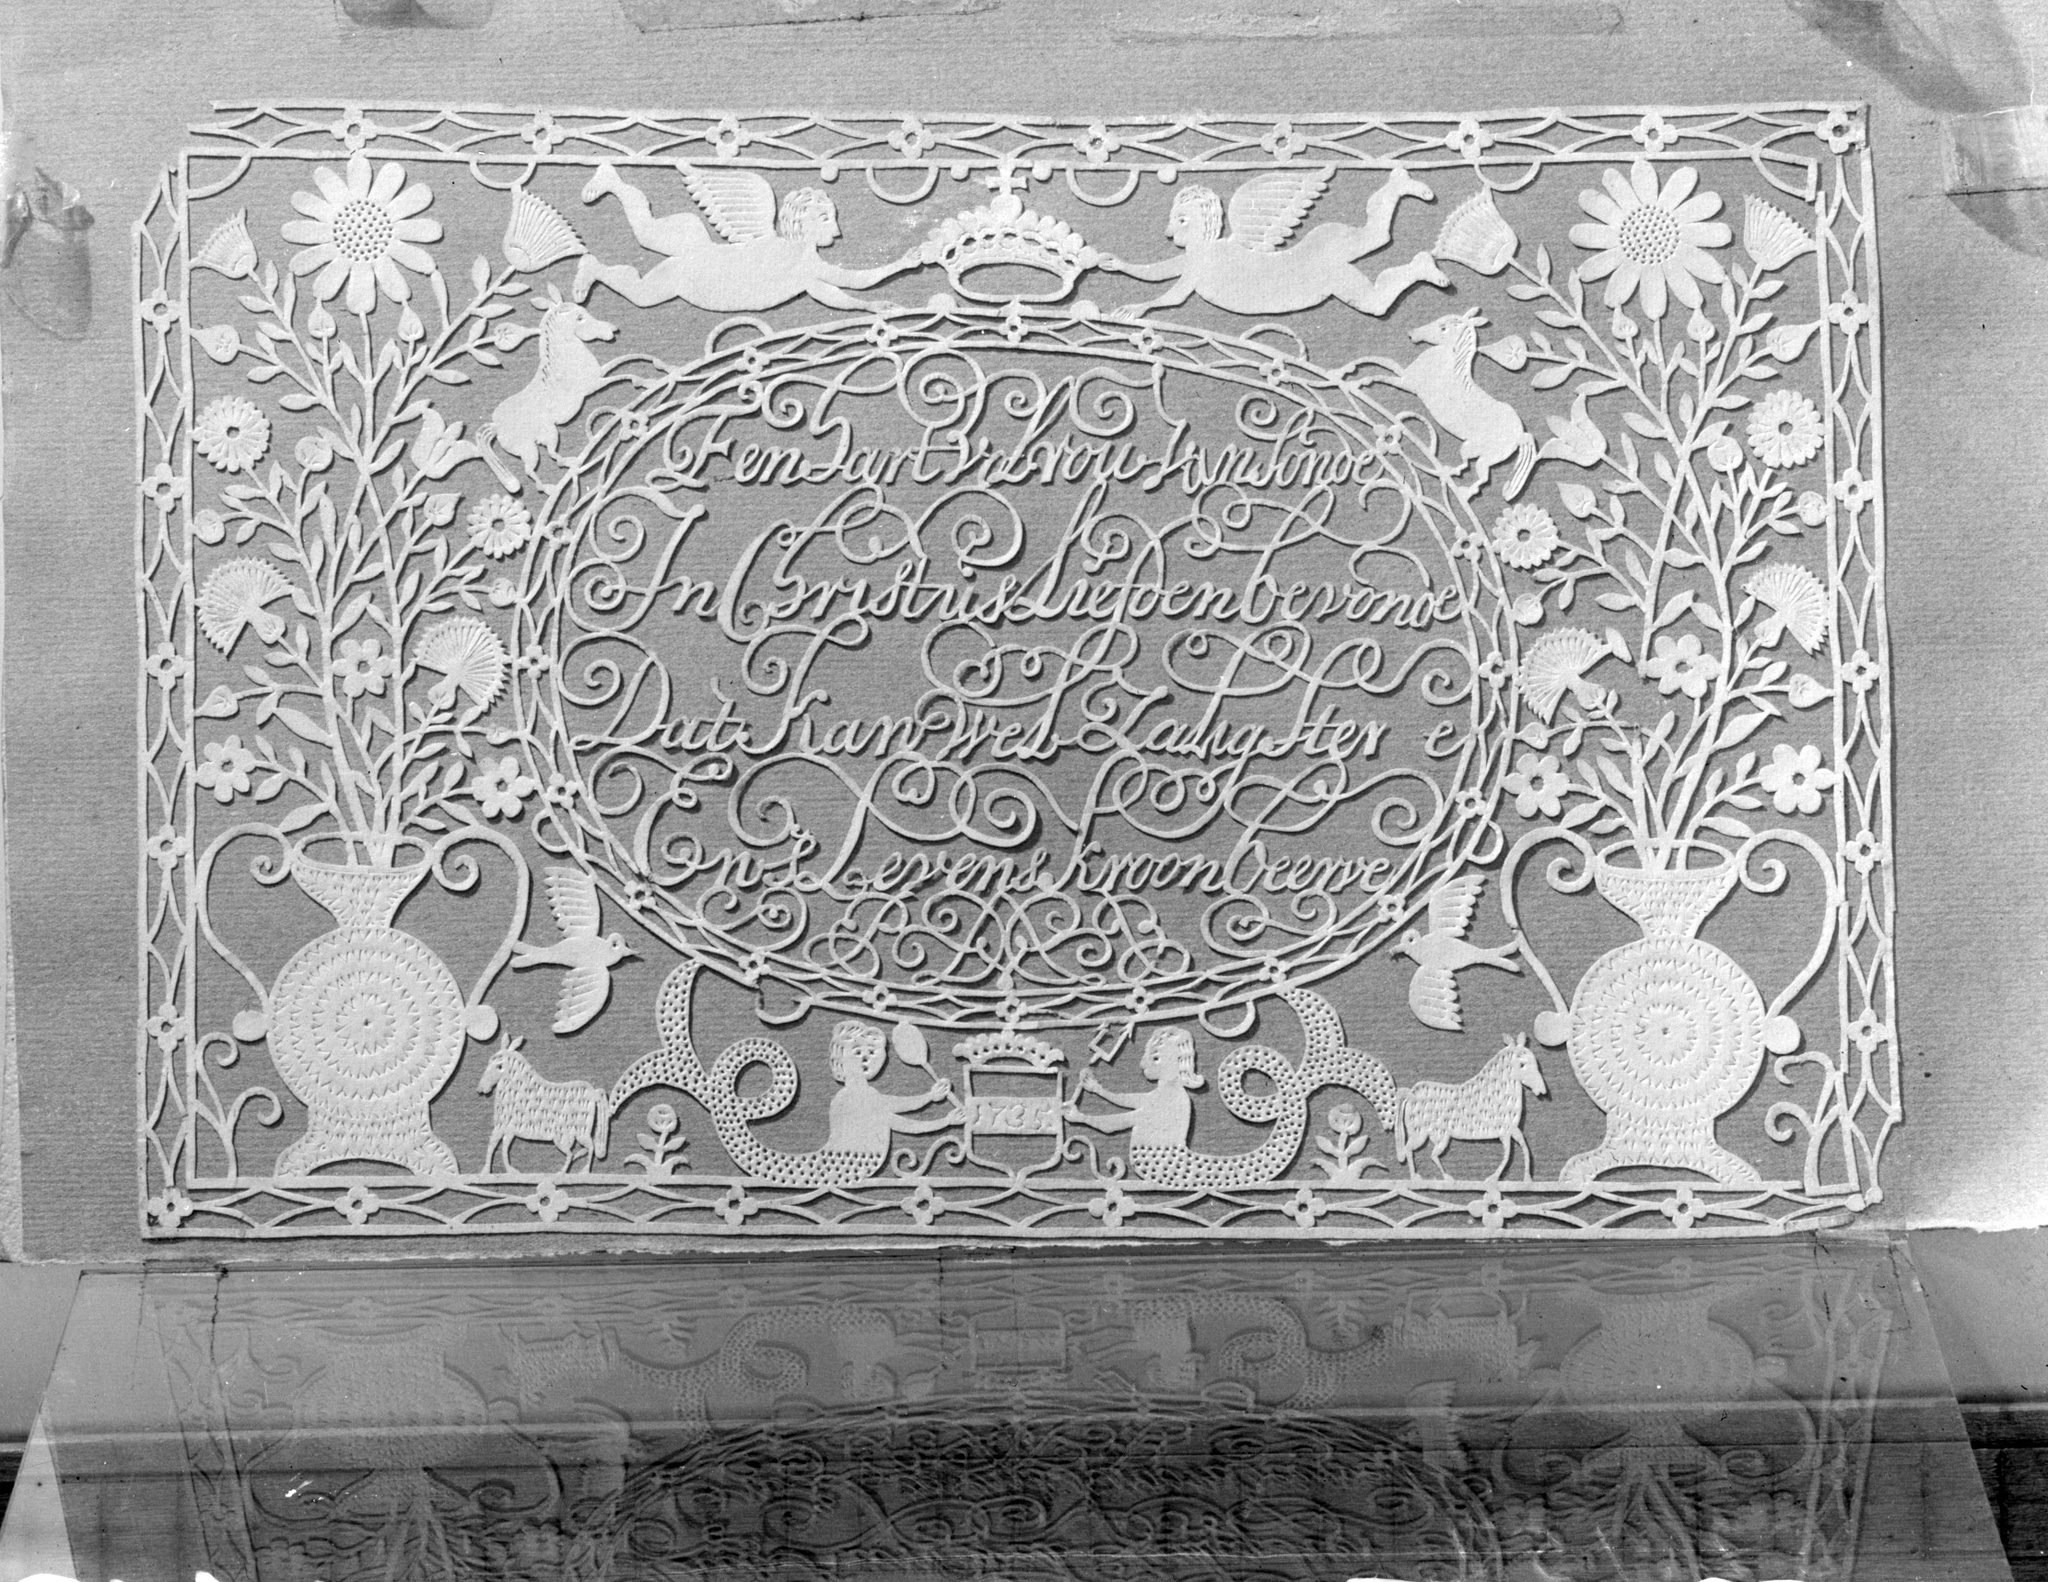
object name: medallion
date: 1735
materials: paper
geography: netherlands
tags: animals,birds,flowers,angels